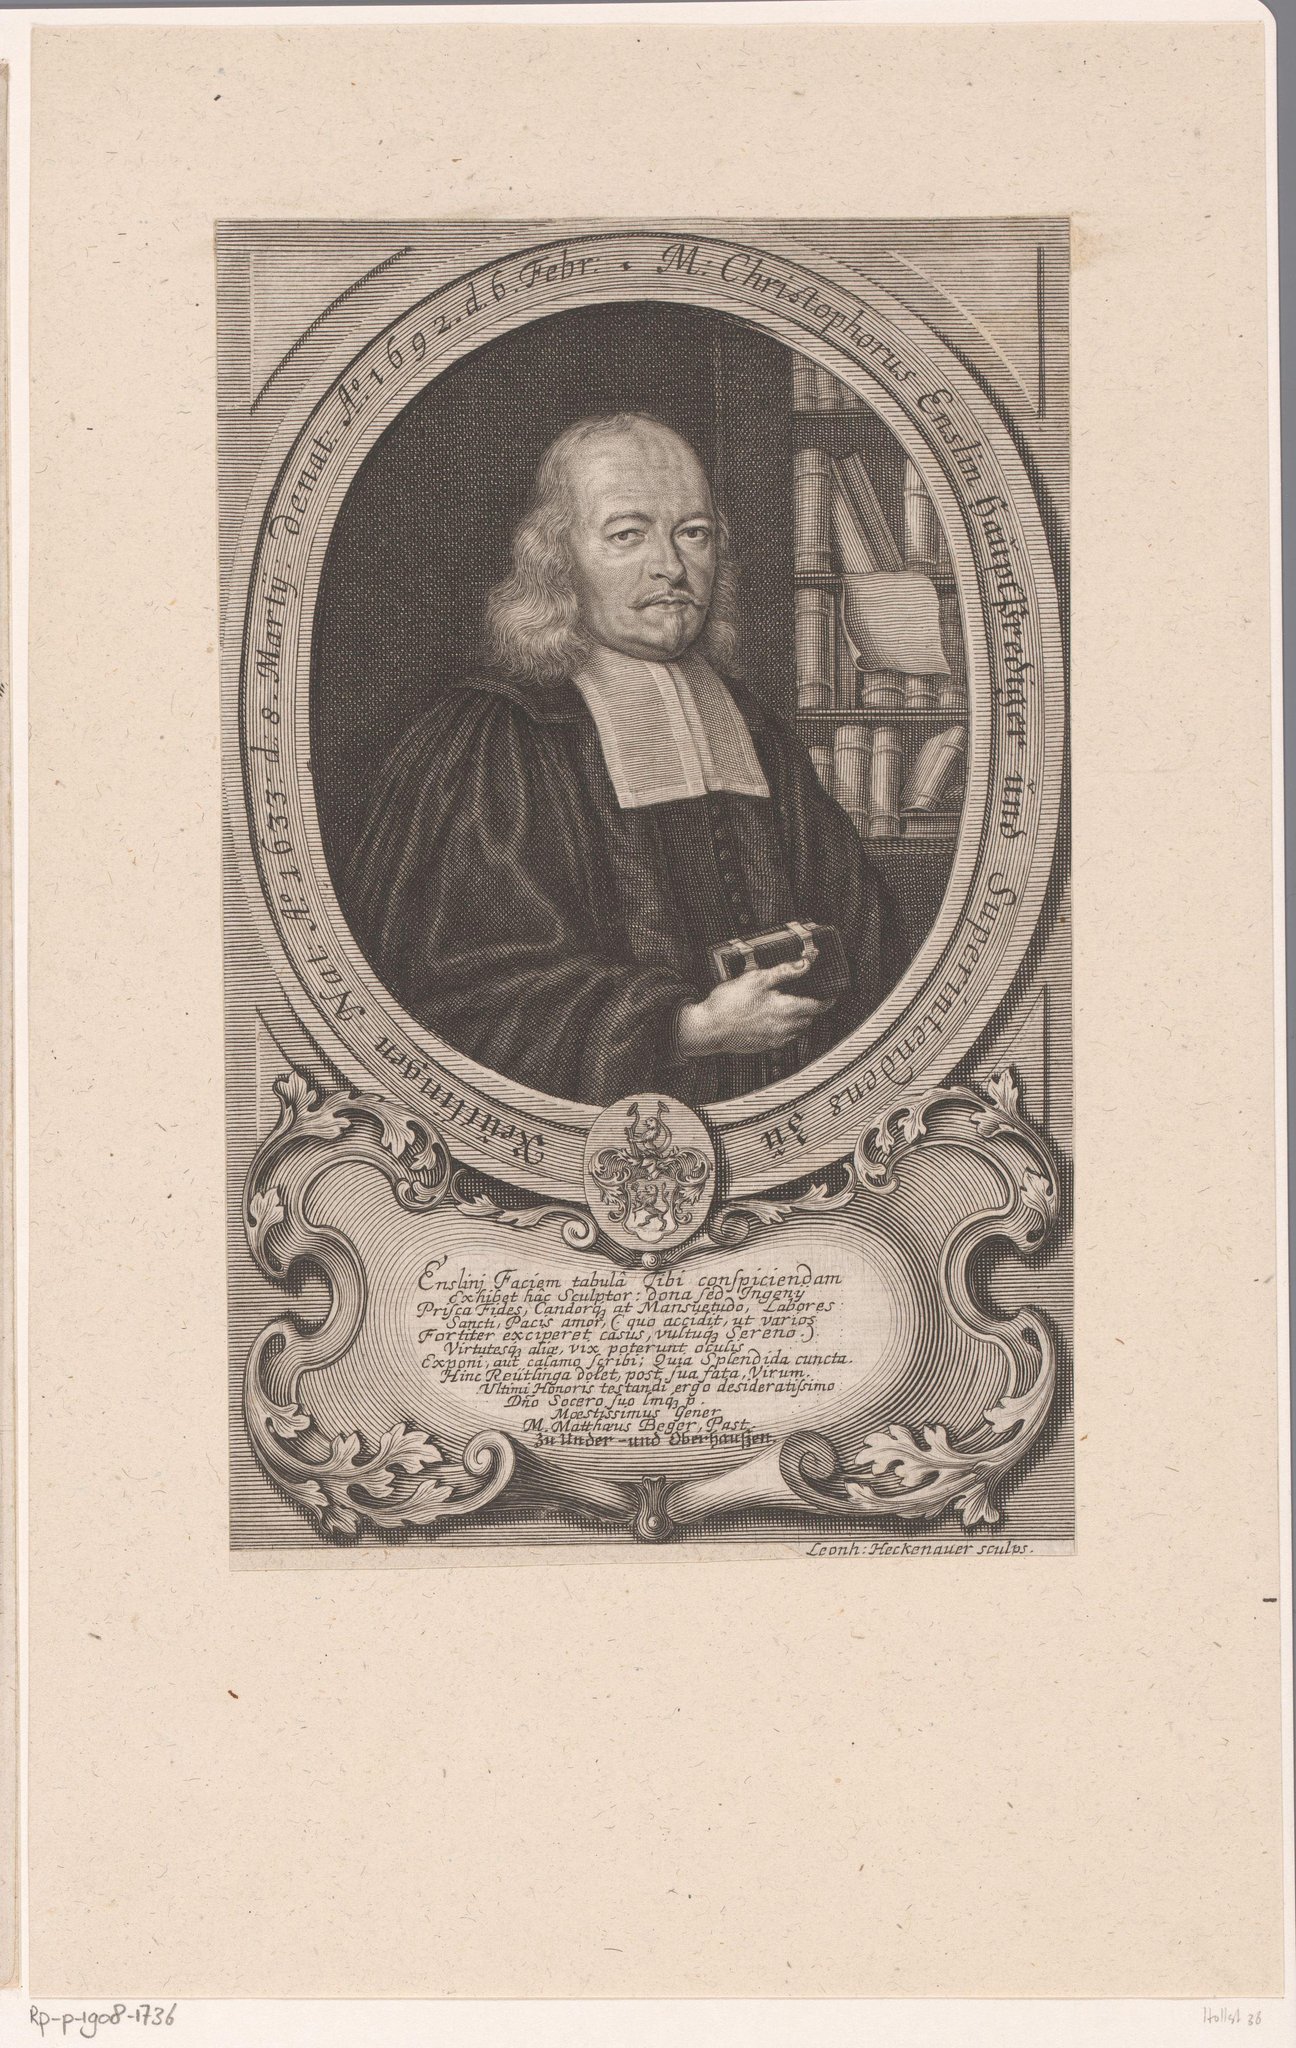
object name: print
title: Portret van Christoph Enslin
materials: paper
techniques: engraving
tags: bookshelves, historical persons, ornament ~ cartouche, armorial bearing, heraldry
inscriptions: collector's mark: Lugt 2228